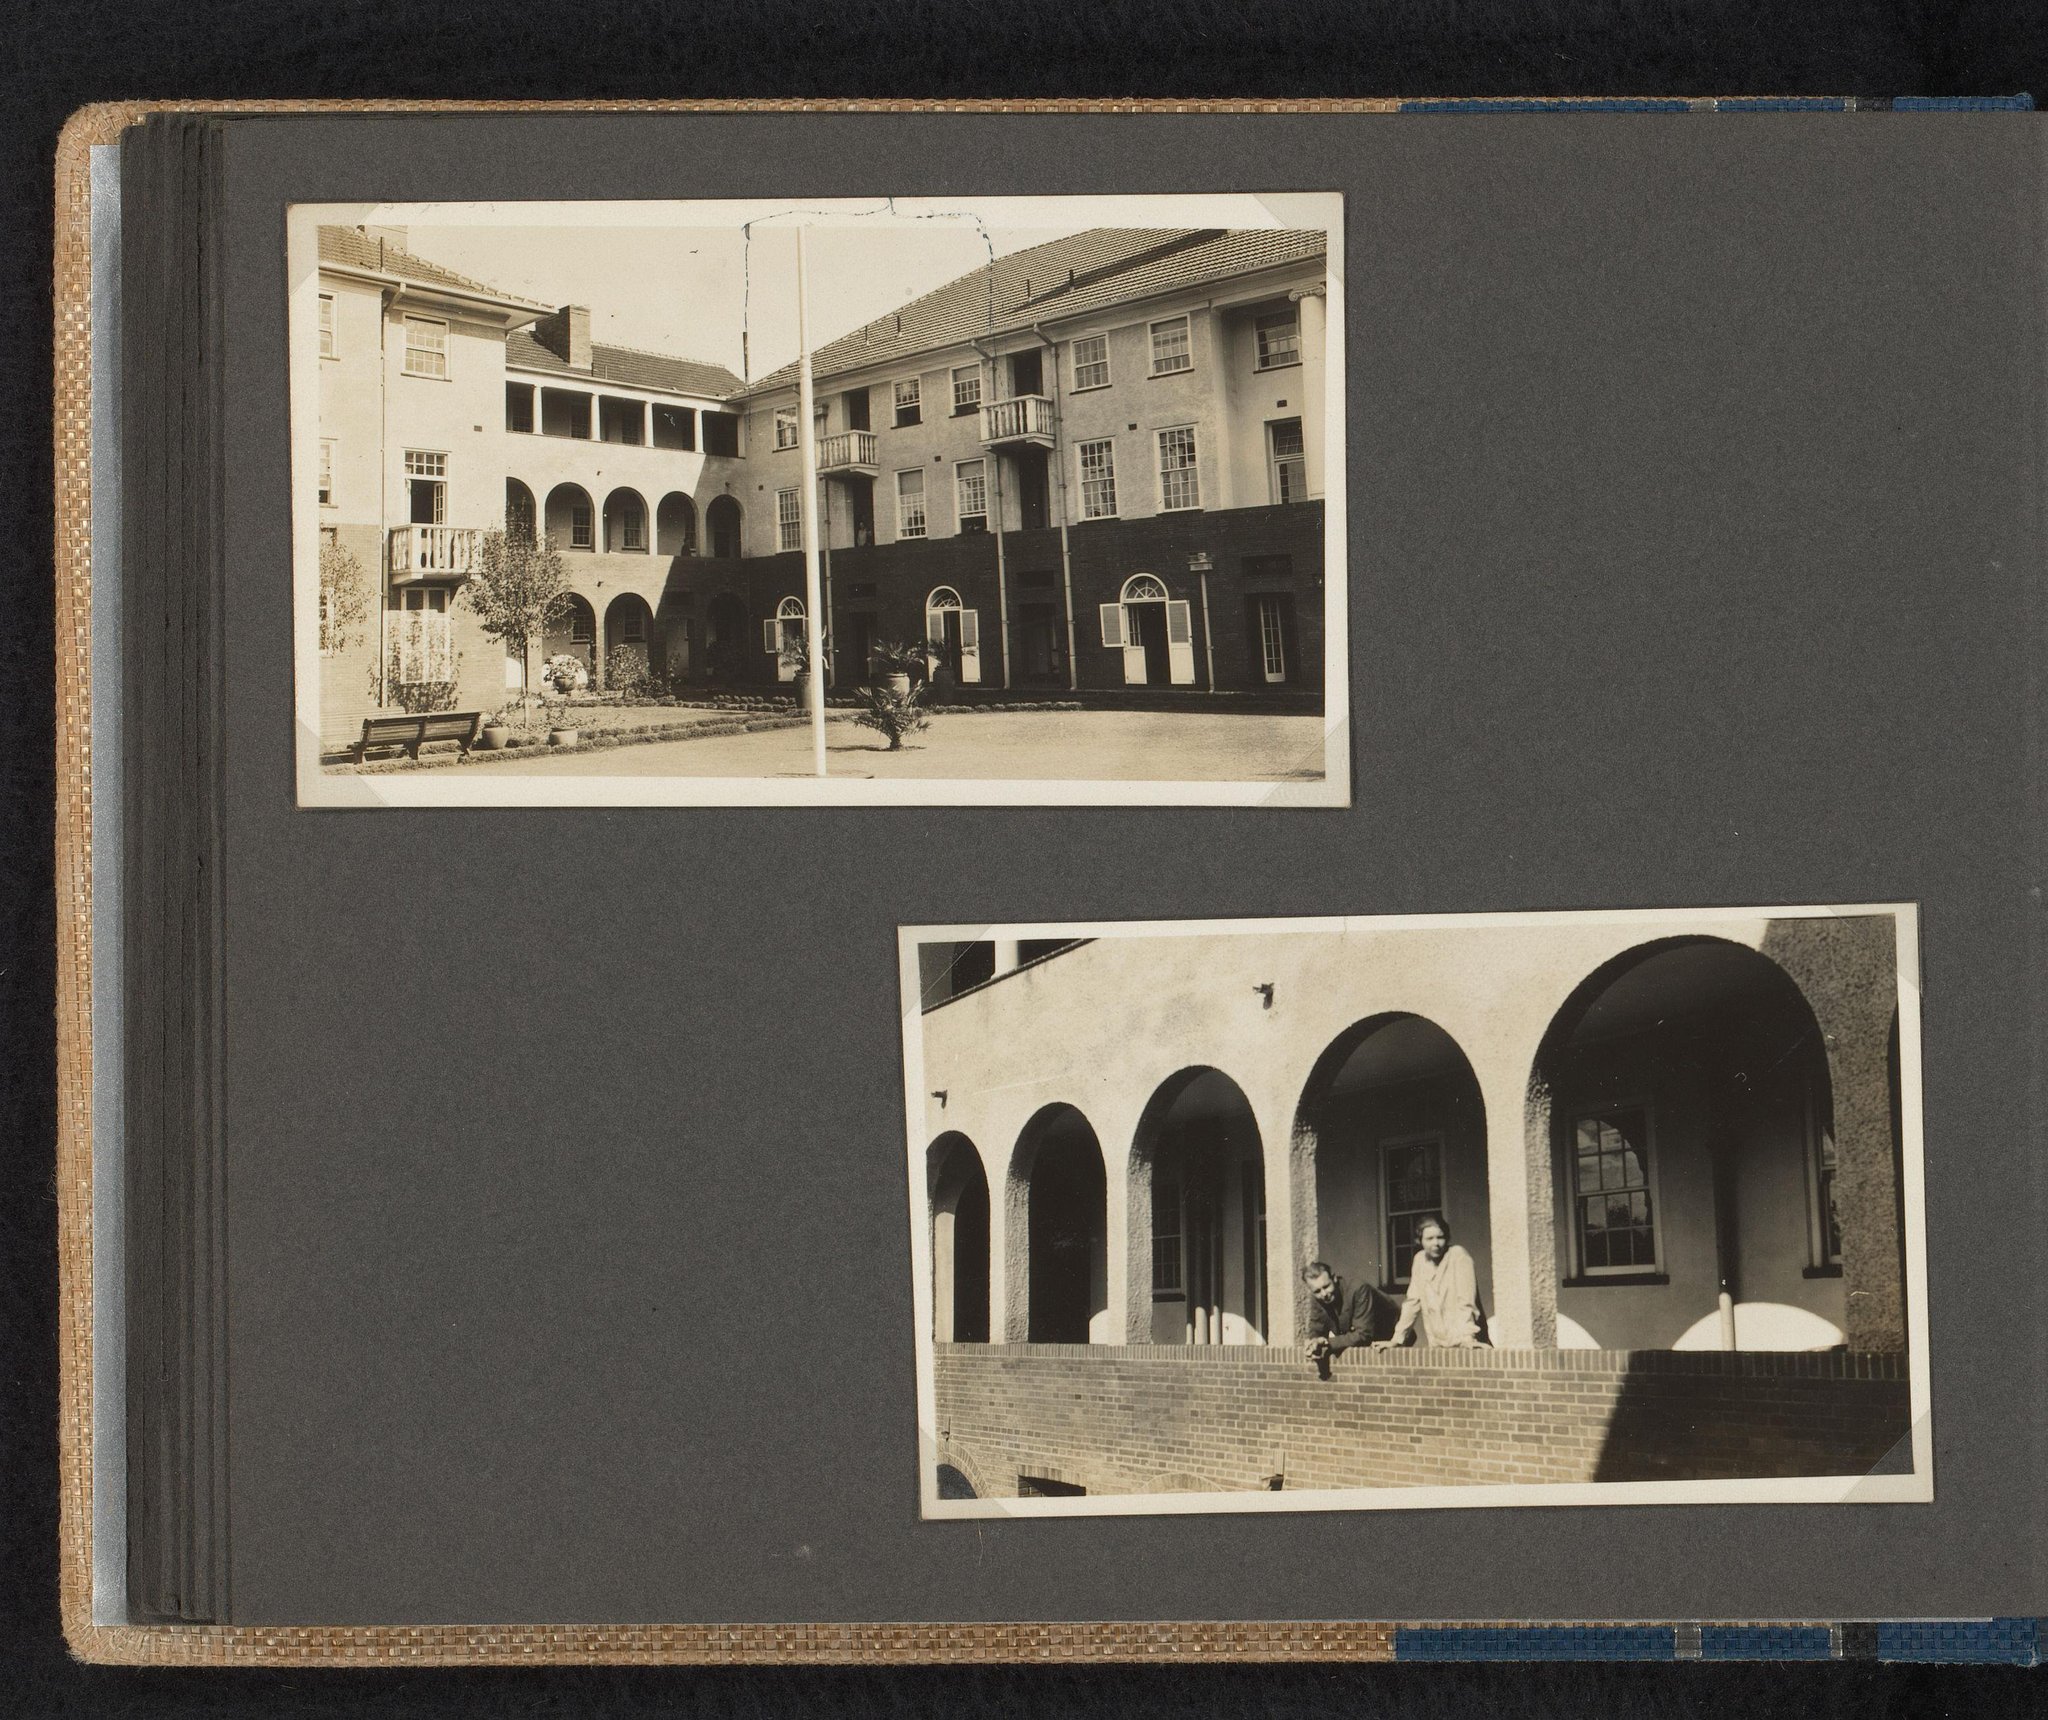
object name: photograph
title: Straatbeeld met galerij in Zuid-Afrika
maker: karel frederik van den berg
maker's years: 1873-1948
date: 1925-1930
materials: paper, cardboard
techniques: gelatin silver print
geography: south africa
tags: street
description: Deze foto's zijn onderdeel van een album.